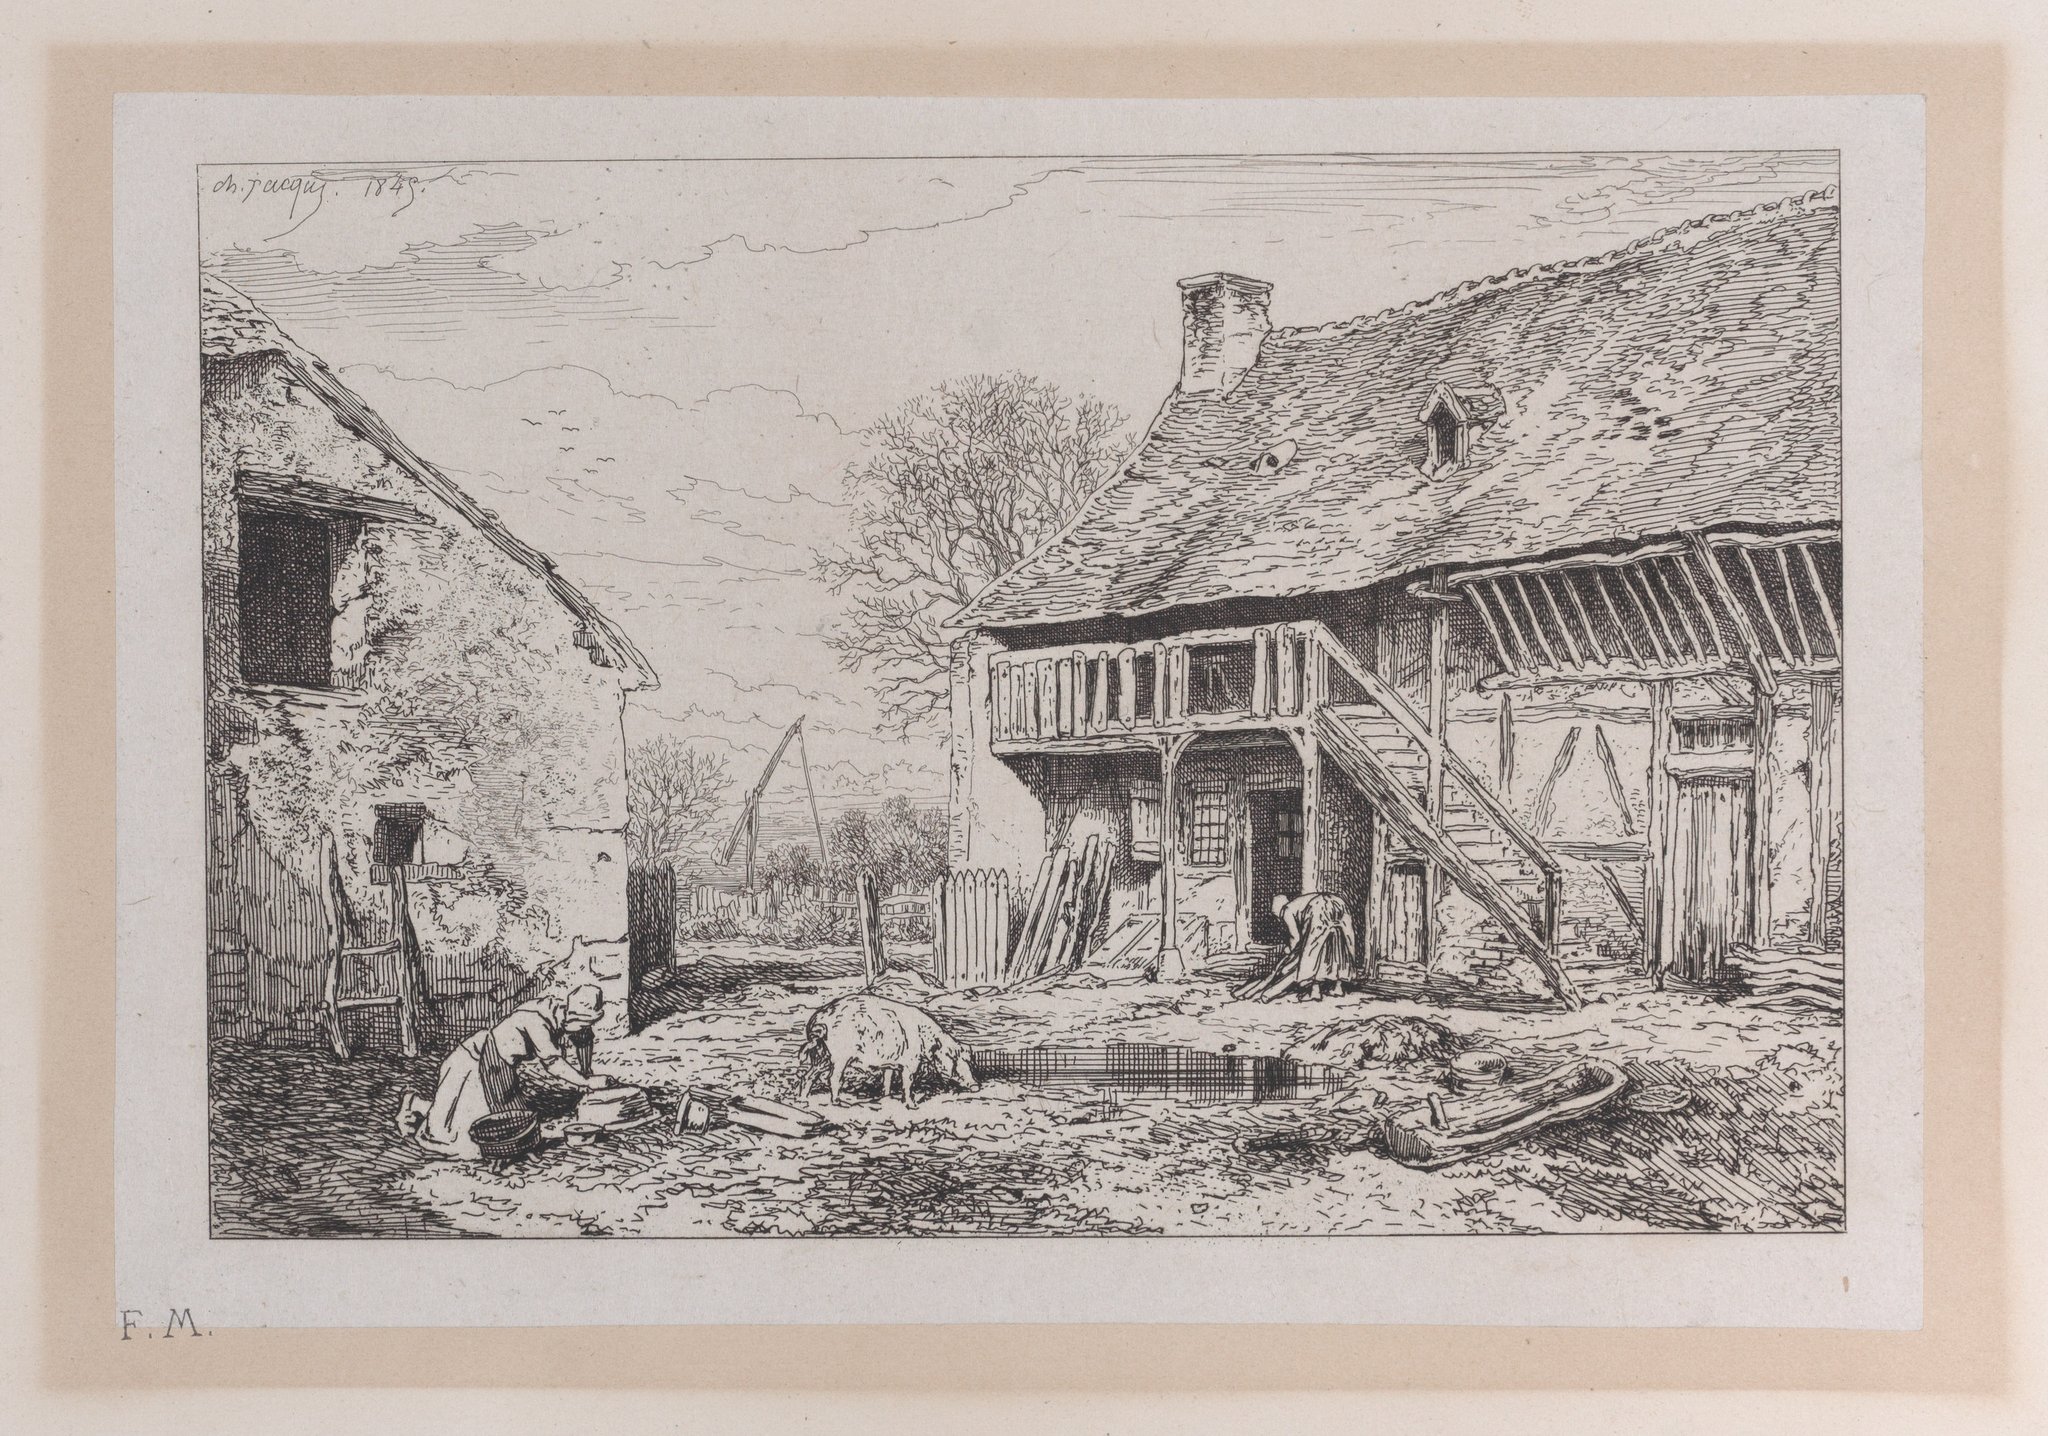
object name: print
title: Landscape of a Peasant's Yard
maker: charles émile jacque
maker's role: artist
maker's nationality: french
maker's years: 1813-1894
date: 1845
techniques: etching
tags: houses,courtyards,women